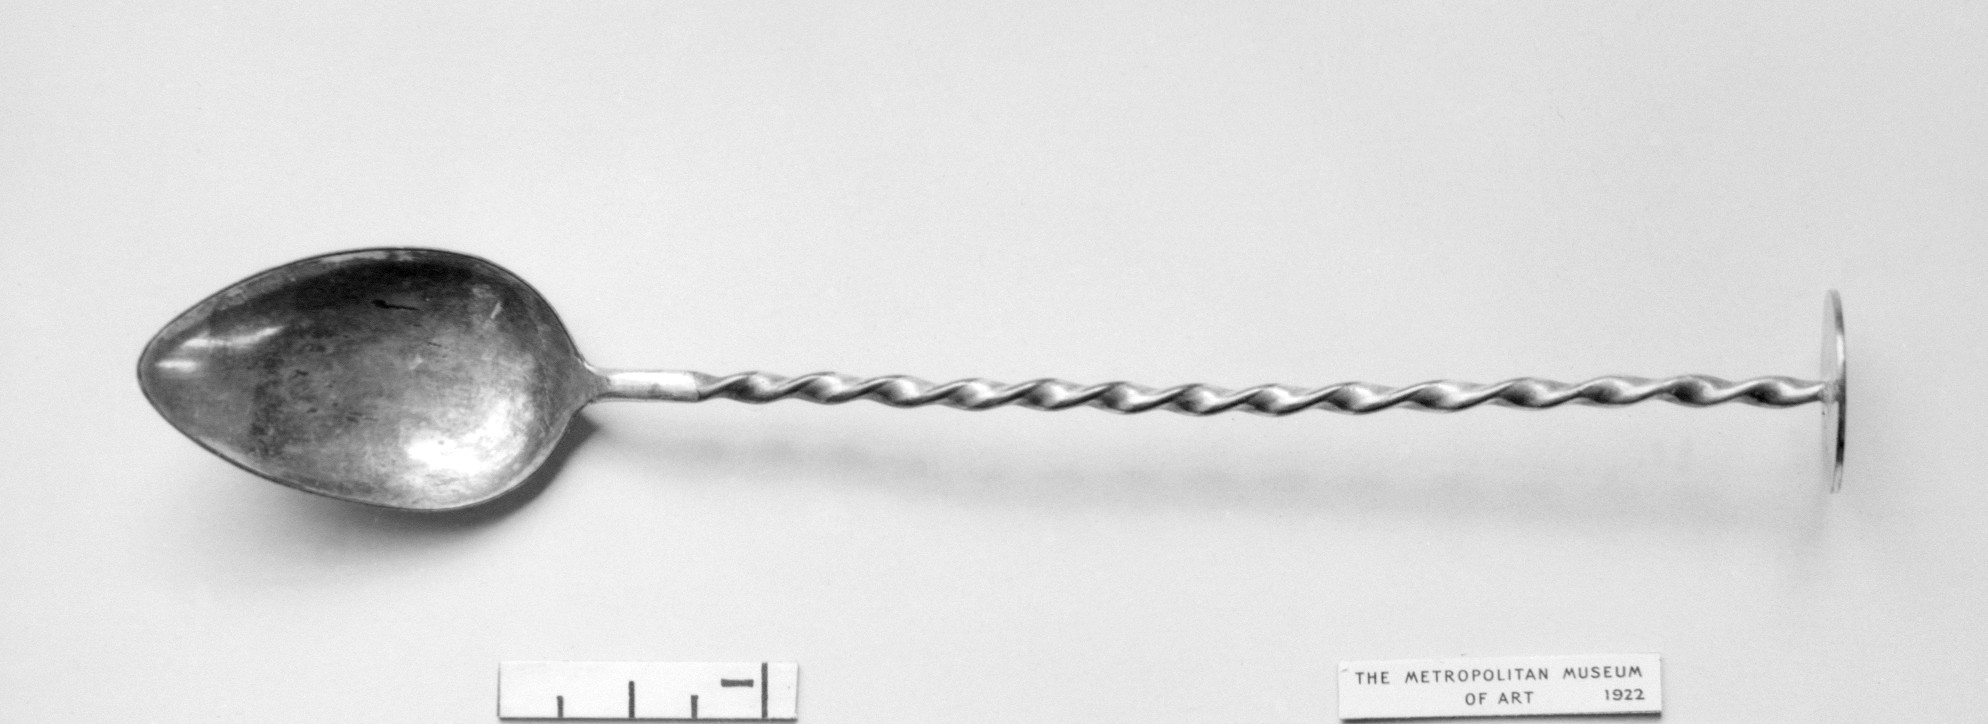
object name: toddy spoon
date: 1770-1800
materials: metal